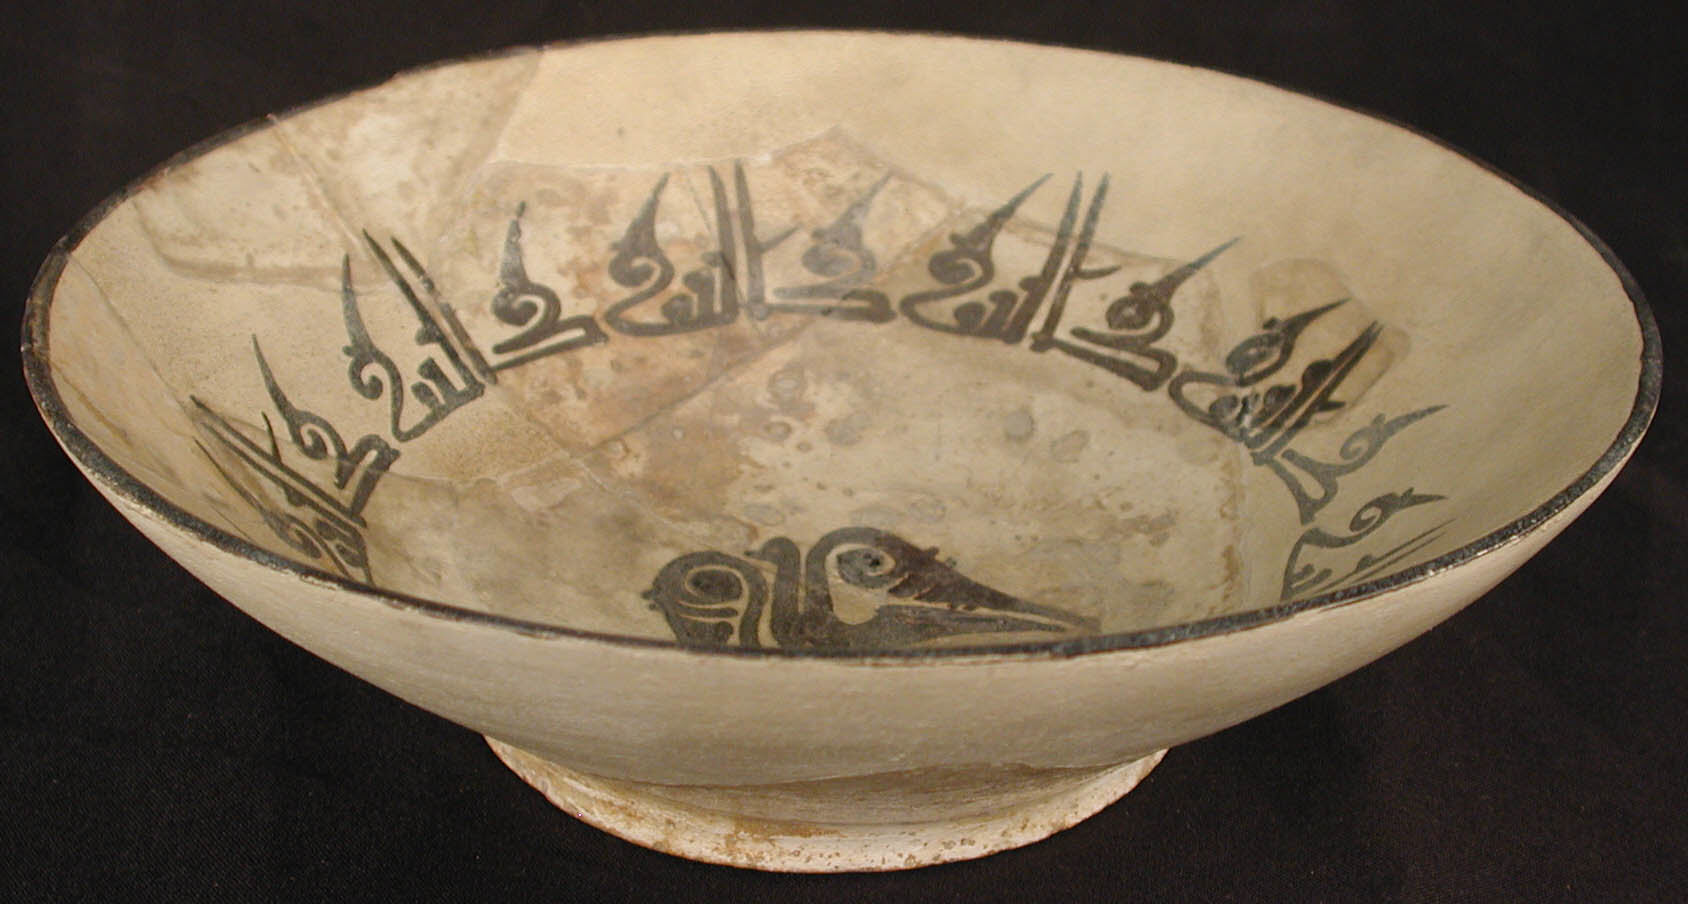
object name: bowl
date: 901-1000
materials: earthenware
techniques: glazing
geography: iran